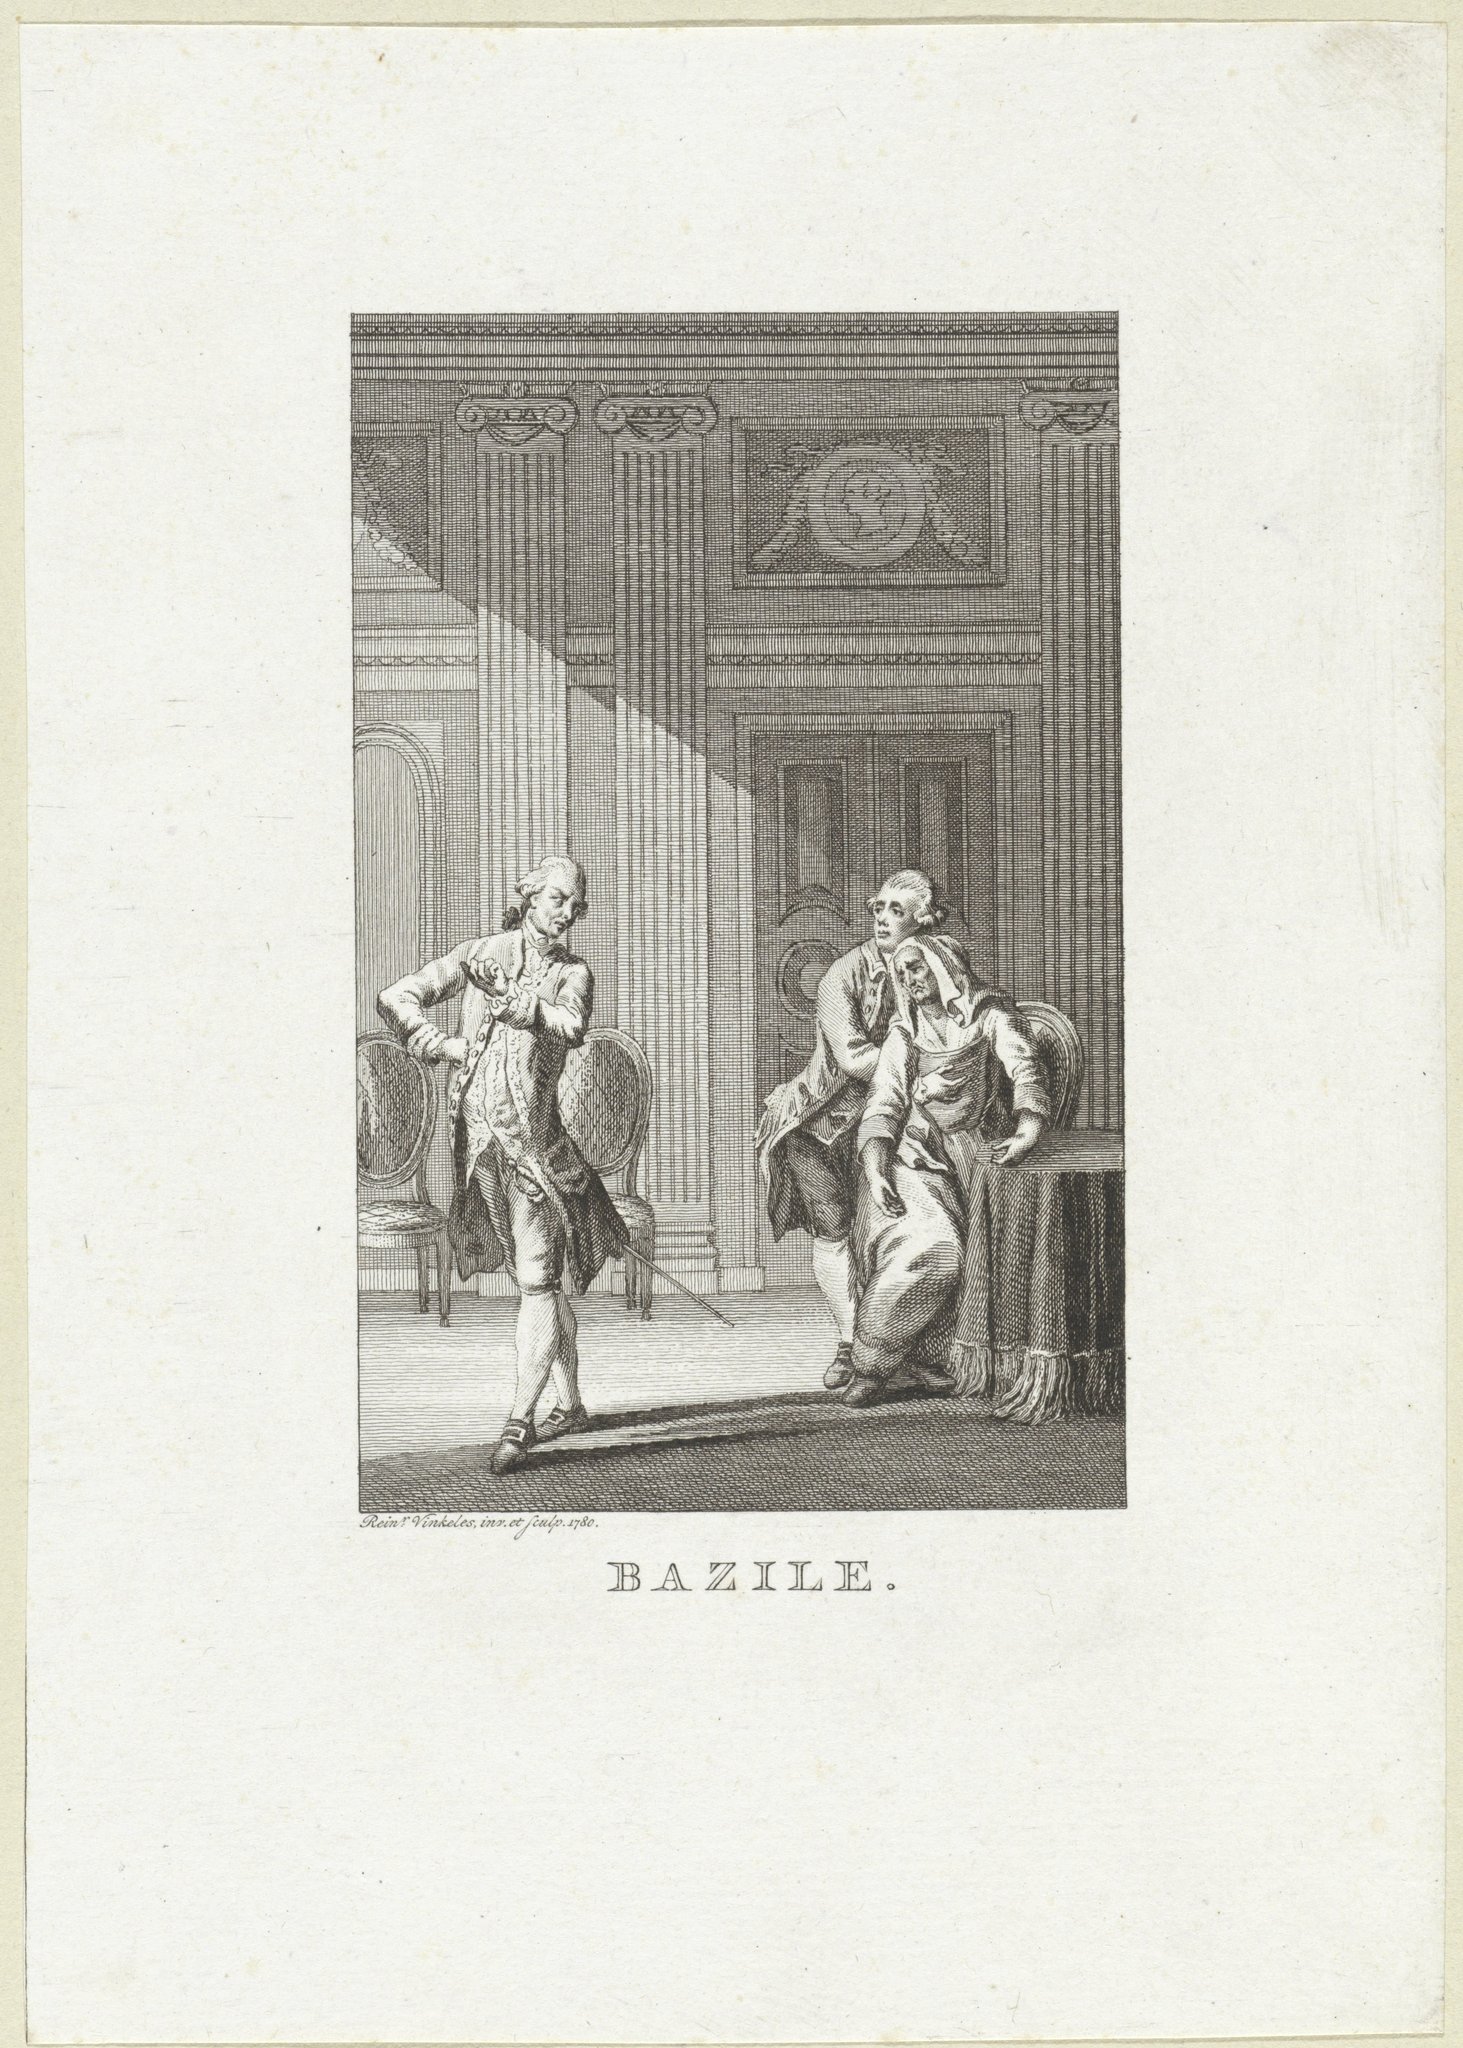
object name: print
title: Geschil tussen drie figuren in een vertrek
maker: reinier vinkeles (i)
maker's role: draughtsman, print maker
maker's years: 1741-1816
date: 1780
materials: paper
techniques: engraving, etching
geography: amsterdam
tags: aggressive relationships, enmity, animosity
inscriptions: collector's mark: Lugt 240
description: Deze prent is ook gebruikt als illustratie bij het verhaal 'Bazile' voor: Baculard d'Arnaud, F.T.M. de. Zedelijke verhaalen, deel 5. Amsterdam: A. Mens Jansz. en A.E. Munnikhuisen, 1780.